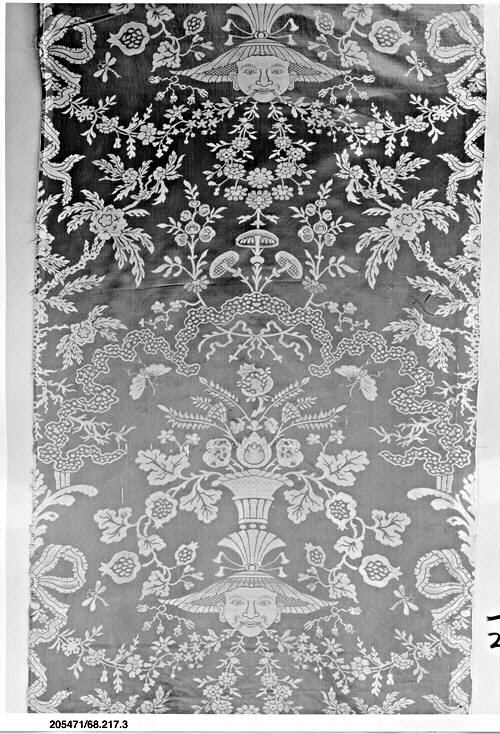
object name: length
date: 1701-1900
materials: silk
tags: faces,flowers